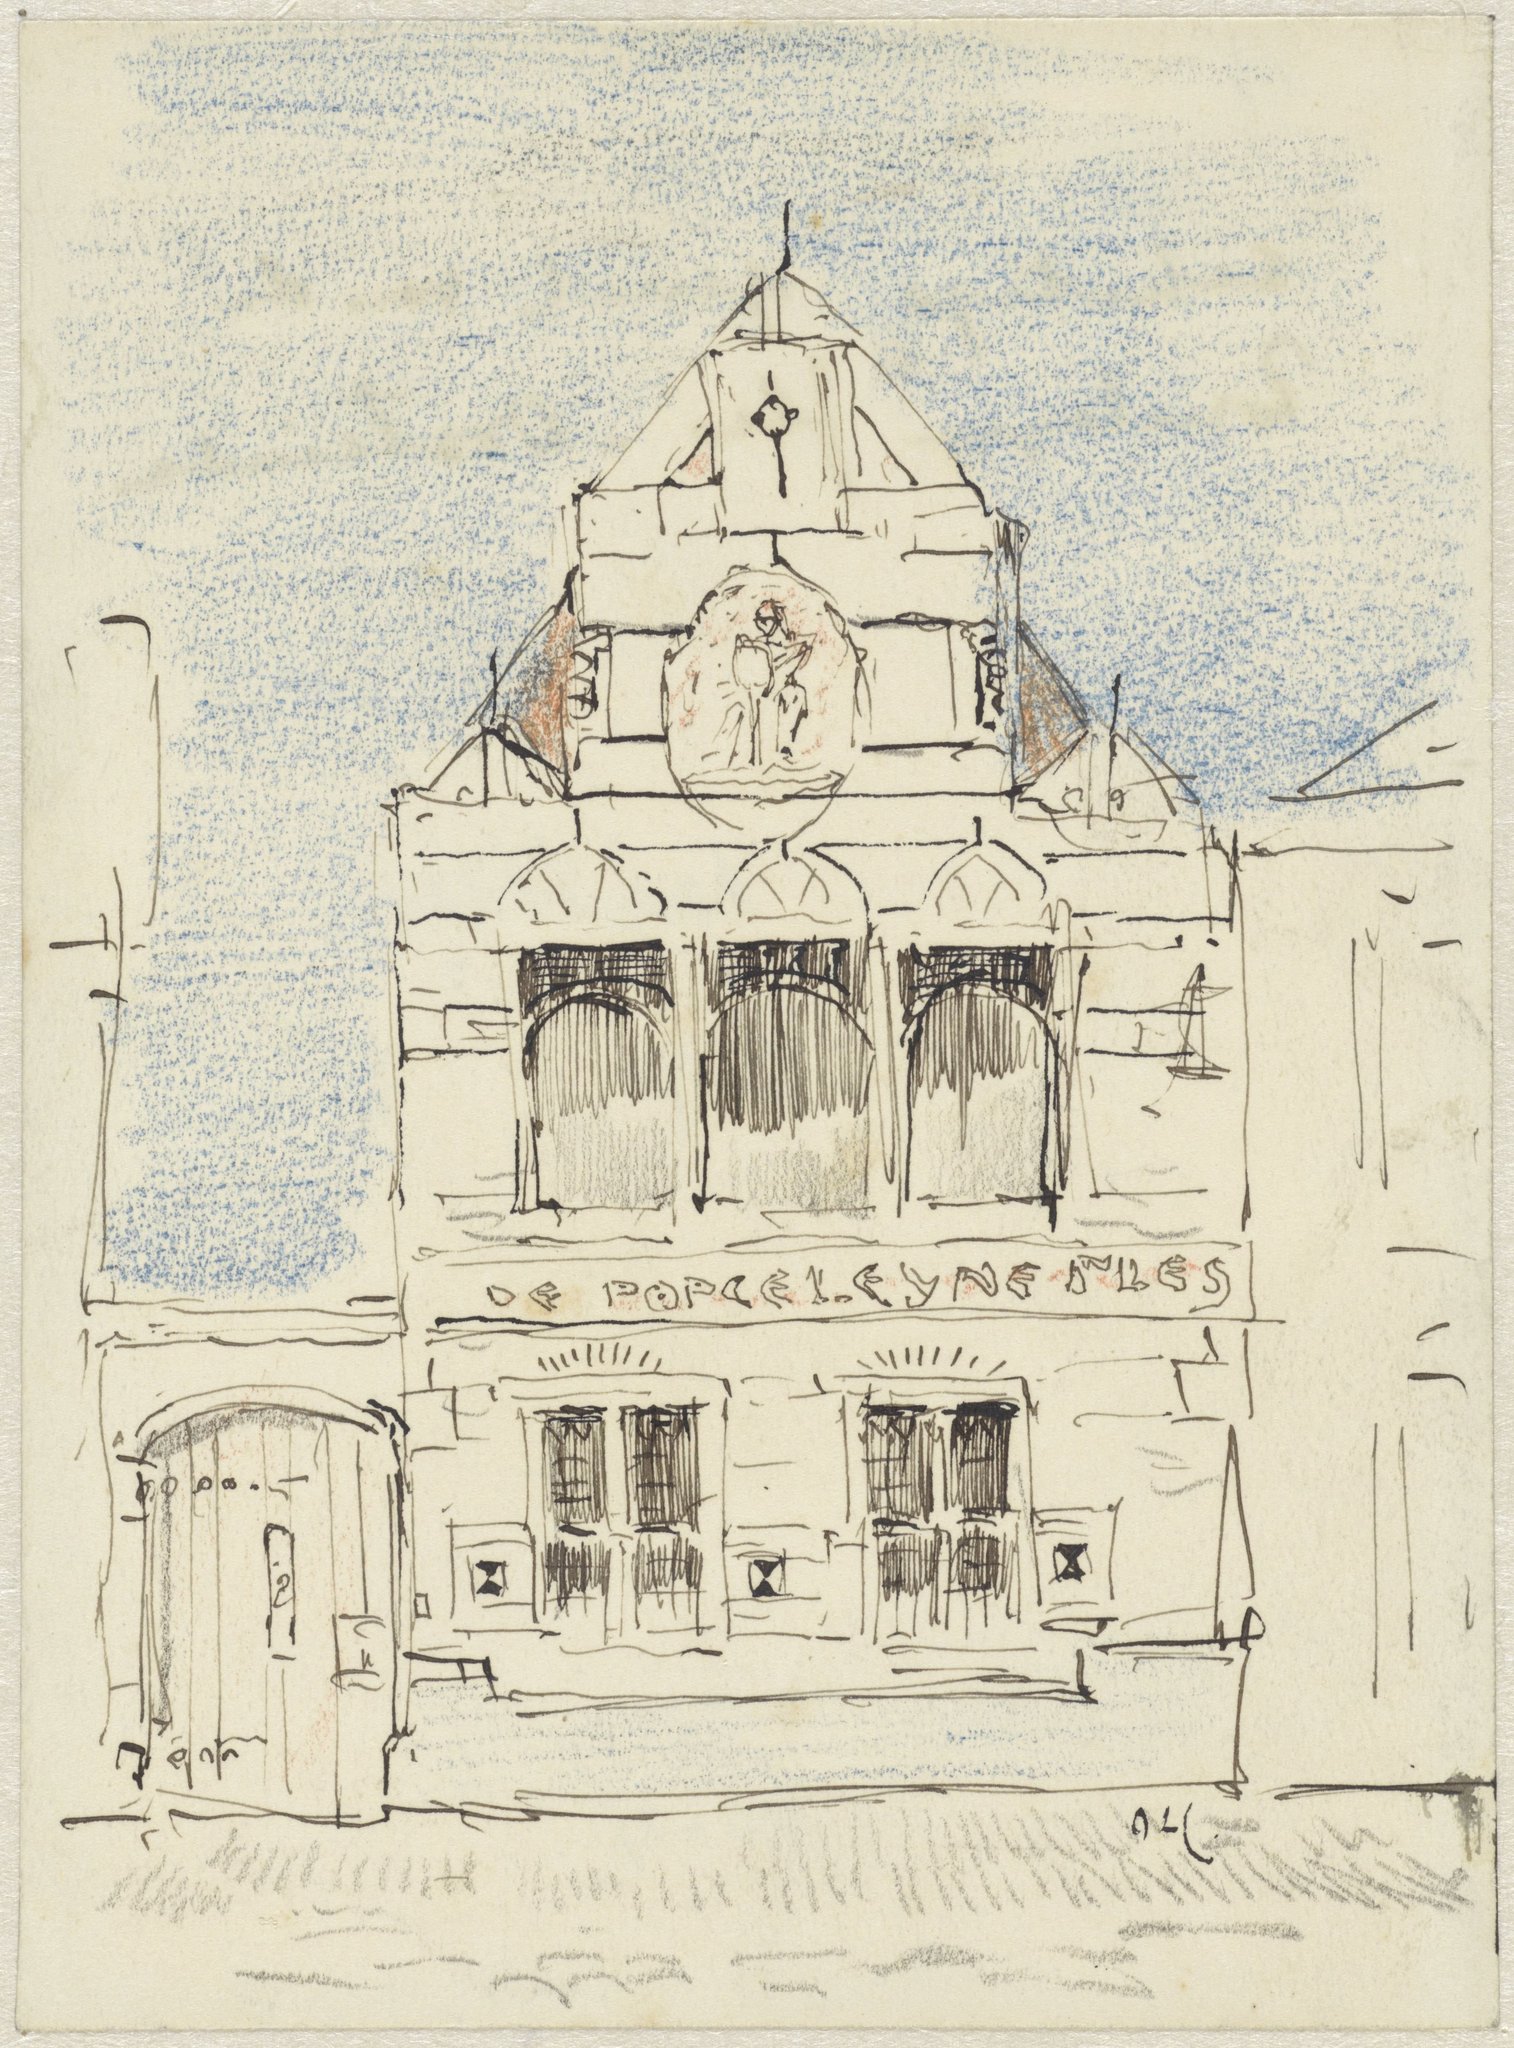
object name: drawing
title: Winkel genaamd De Porceleyne Fles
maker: adolf le comte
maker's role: draughtsman, painter, print maker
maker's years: 1850-1921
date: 1860-1921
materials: chalk, ink, paper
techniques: pen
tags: shop, store, urban housing, delft